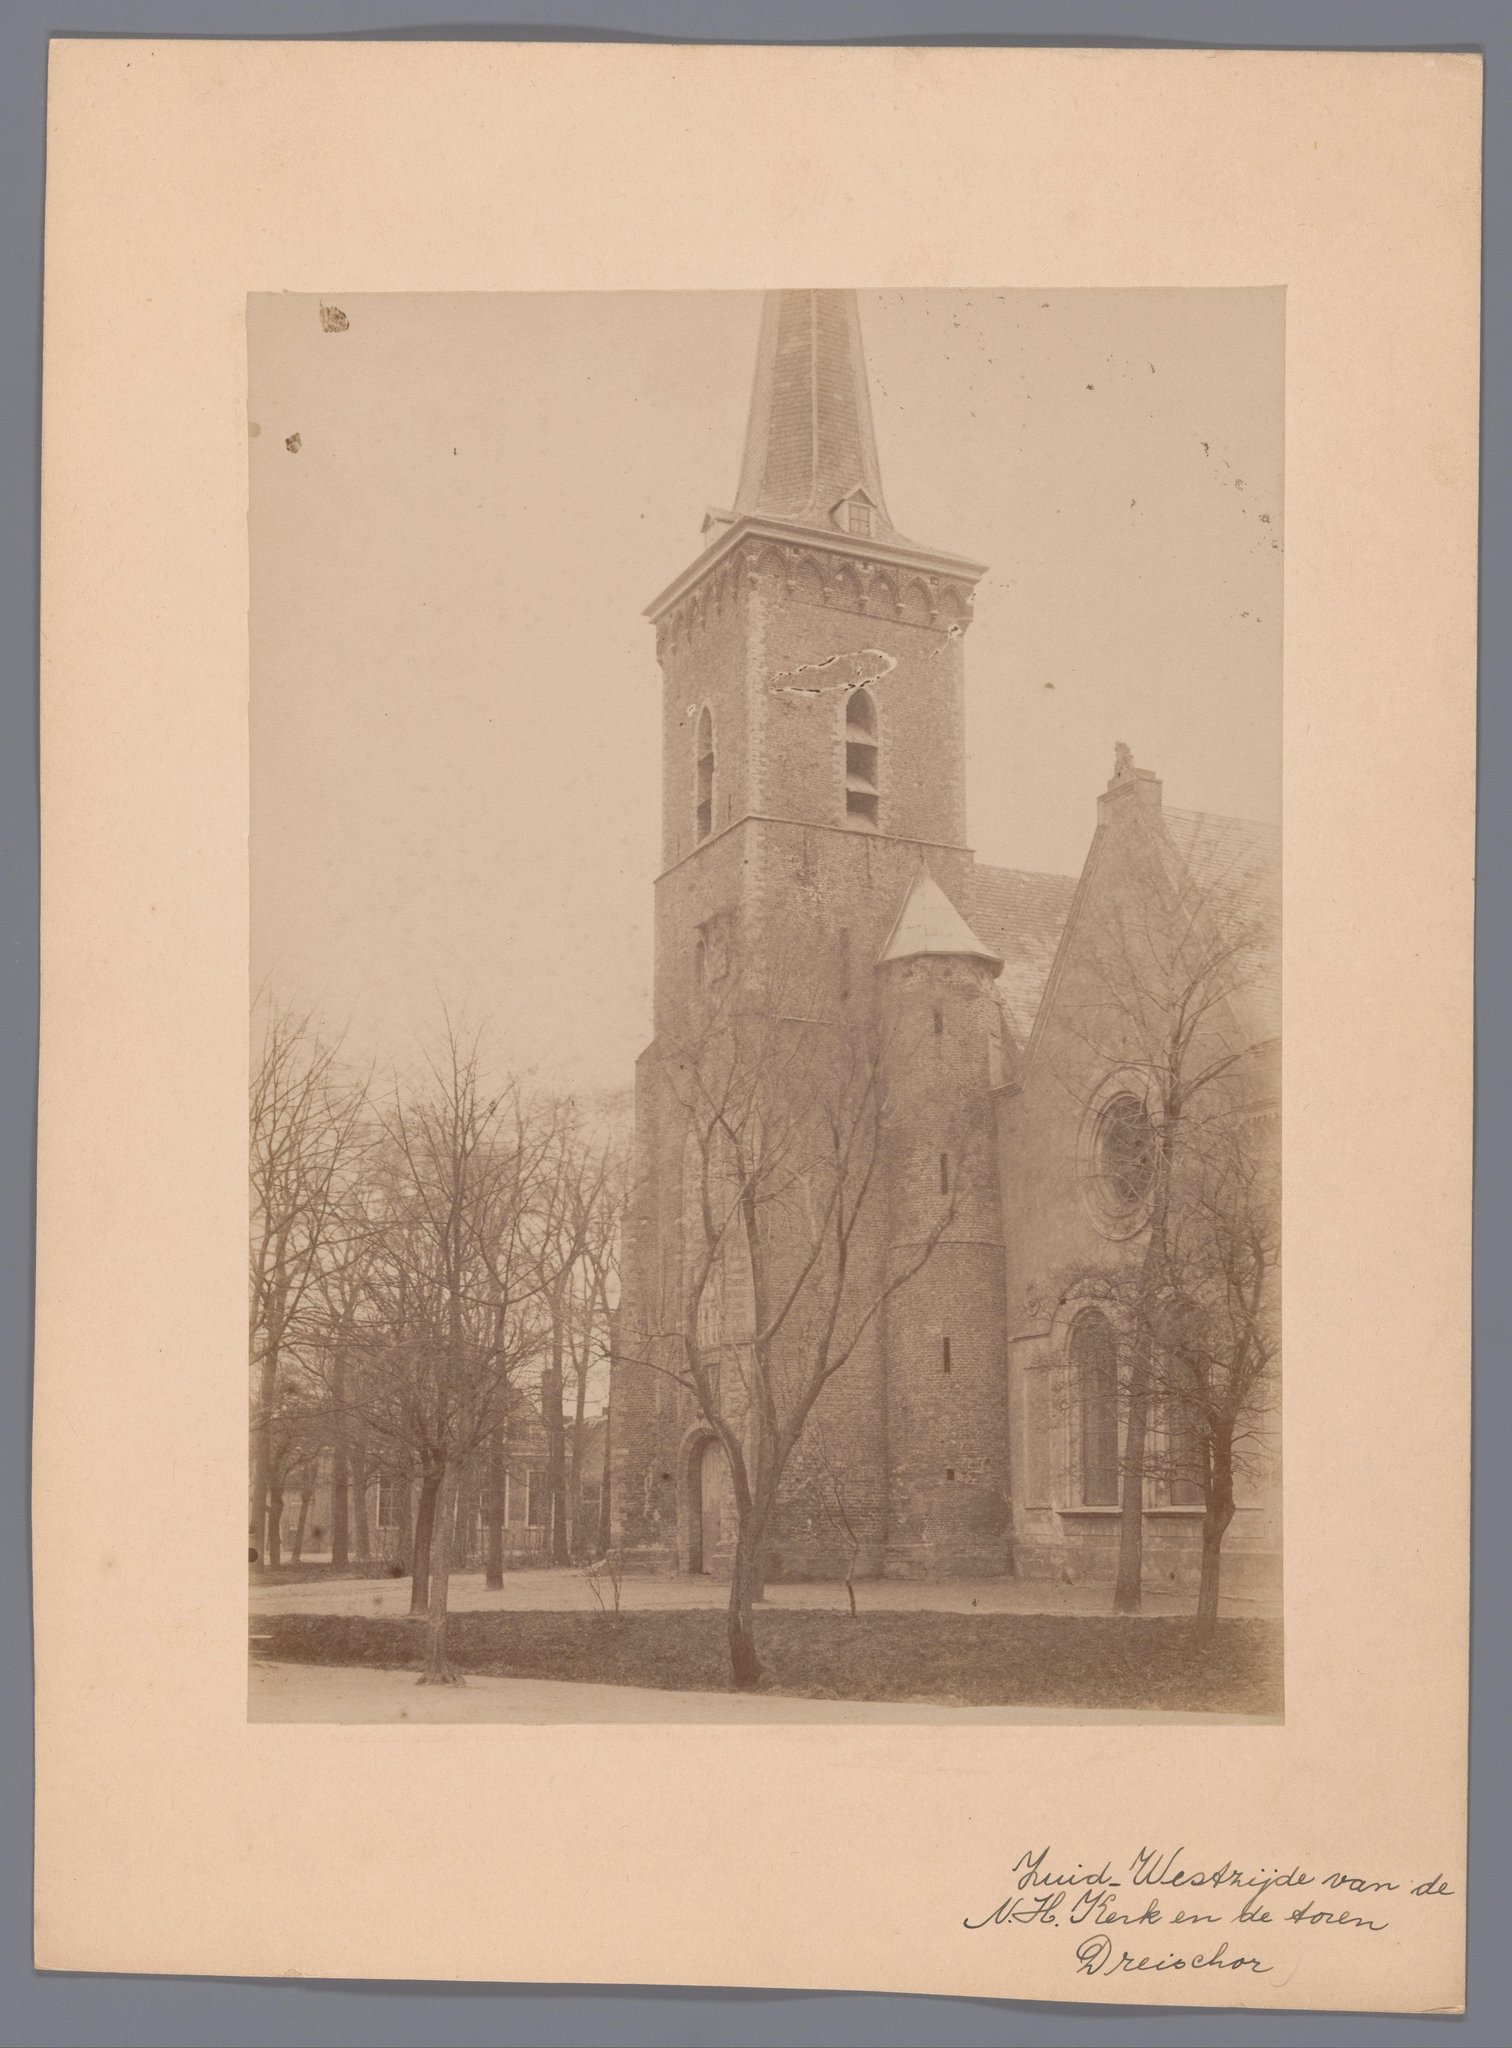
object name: photograph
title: Toren van de Sint-Adriaanskerk te Dreischor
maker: anoniem (monumentenzorg)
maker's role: fotograaf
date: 1893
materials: cardboard, photographic support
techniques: albumen print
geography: dreischor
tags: parts of church exterior and annexes: tower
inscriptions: annotation: ‘Zuid-Westzijde van de N.H. Kerk en de toren/ Dreischor’, annotation: ‘Dreischor op het eiland Schouwen/ Zeeland/ Zuid West zijde van de kerk en den toren/ Maart 1893’